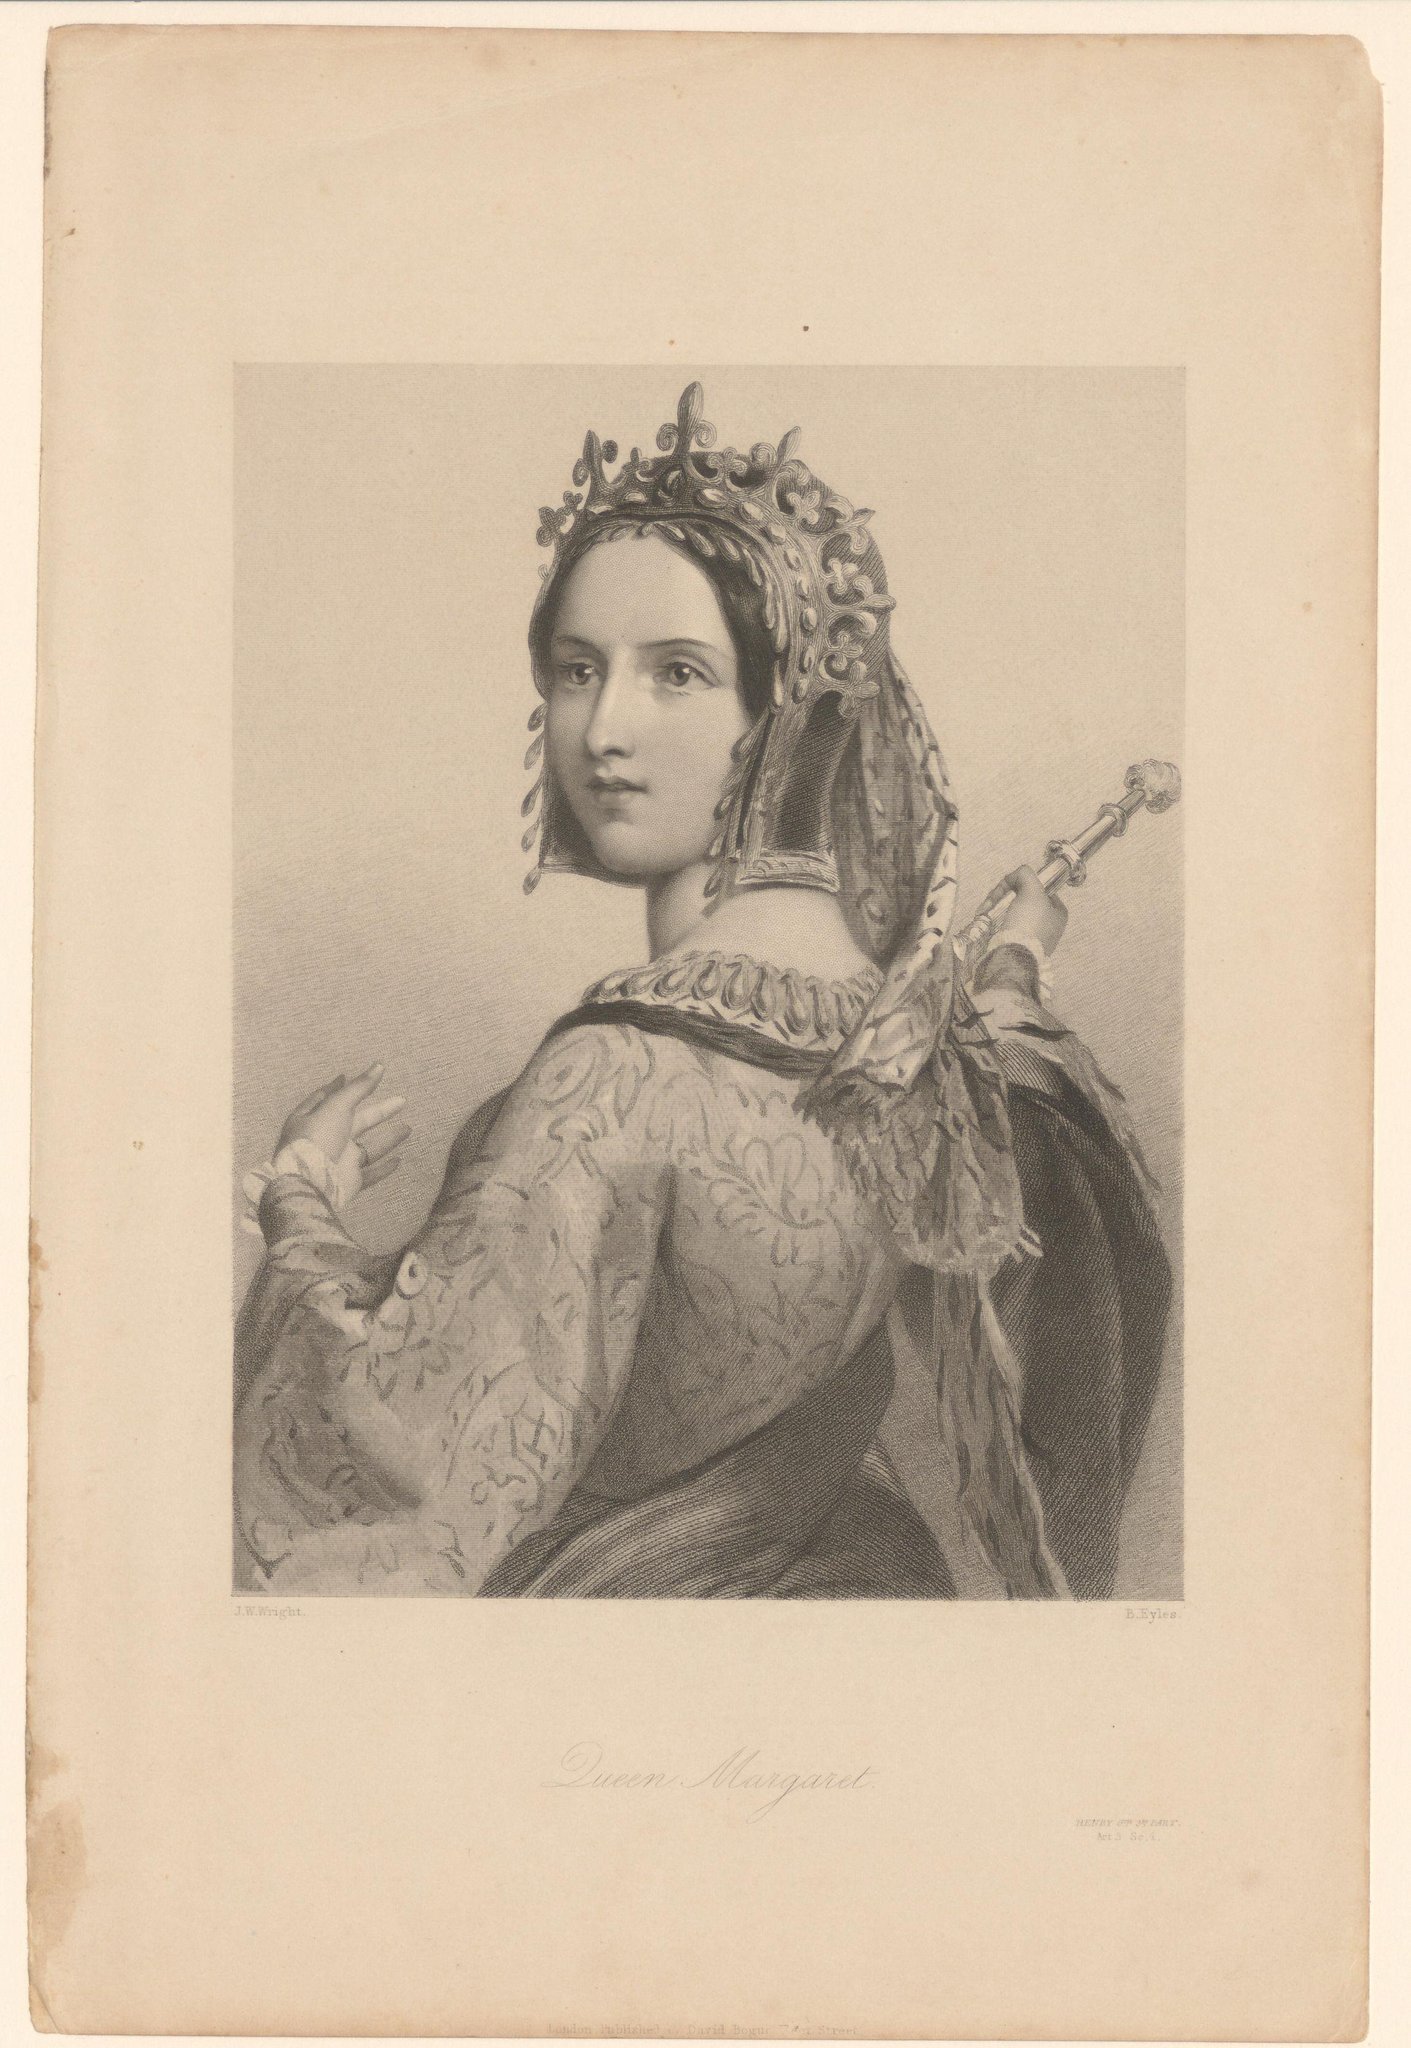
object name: print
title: Queen Margaret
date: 1847-1848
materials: paper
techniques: etching, roulette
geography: london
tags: william shakespeare, female literary characters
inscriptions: collector's mark: Lugt 2228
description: Prent ook gebruikt in: Heath, Charles. The heroines of Shakespeare: comprising the principal female characters in the plays of the great poet. Londen: David Bogue, 1848.